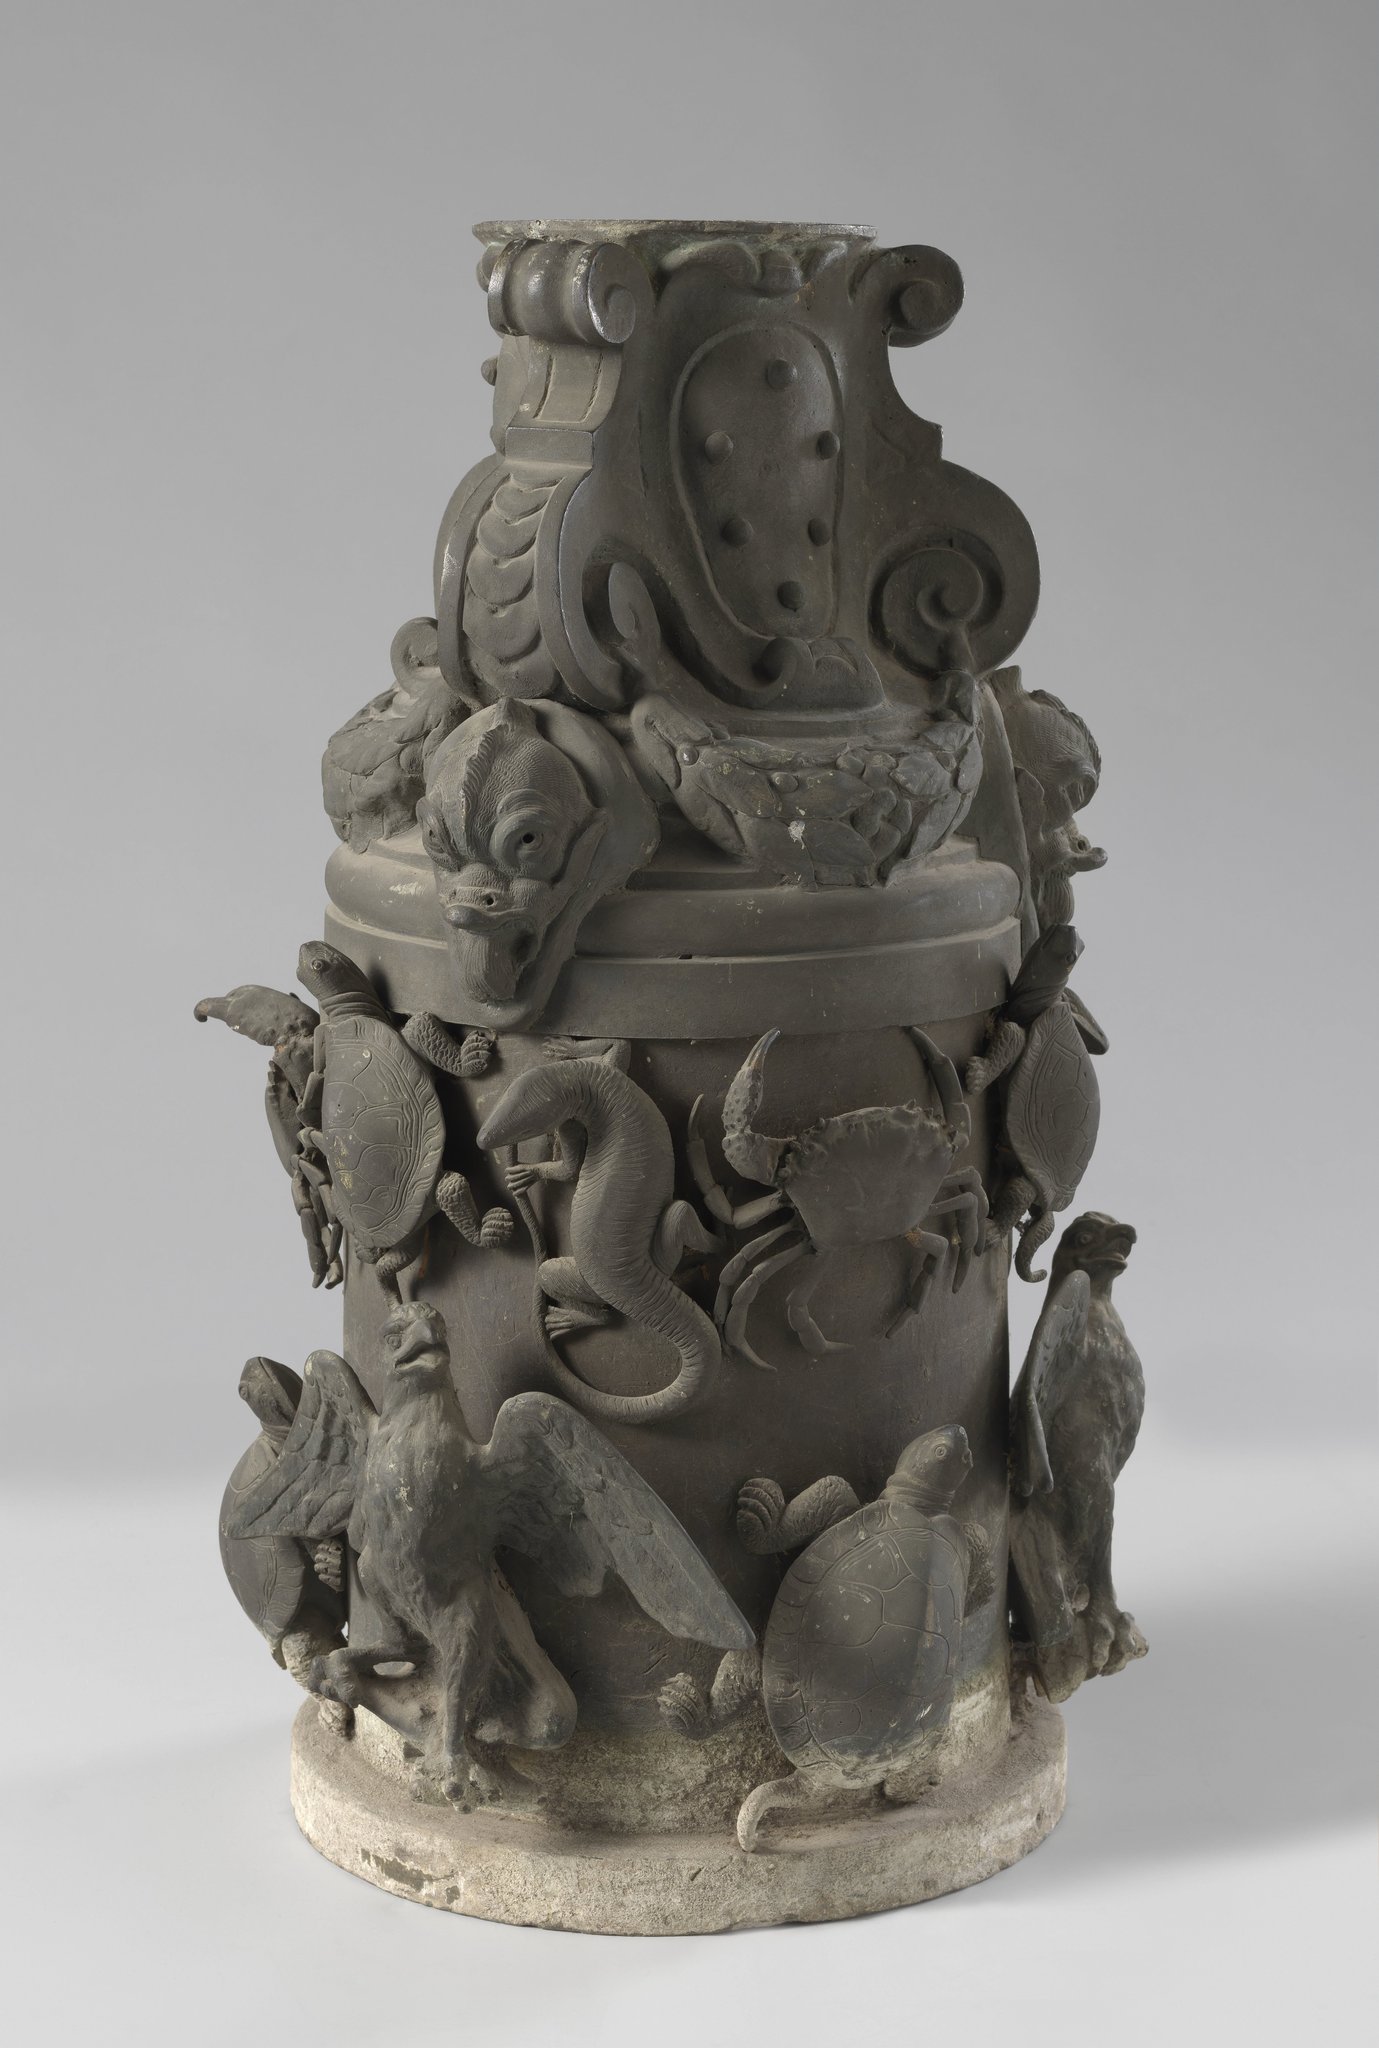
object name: sculpture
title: Cilinder met roofvogels, schildpadden, kreeften en hagedissen, onderdeel van een fontein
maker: Anonymous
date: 1800-1900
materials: bronze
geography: italy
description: Op een cilindervormige basis, waarop roofvogels, schildpadden, kreeften en hagedissen zijn aangebracht, staat een voetstuk, waarvan de drie zijden worden gevormd door een cartouche, waarop het Medici-wapen. Deze cartouches worden gescheiden door drie steunberen in de vorm van zware voluten, die onderling verbonden zijn door guirlandes. Onder elke voluut een masceron.